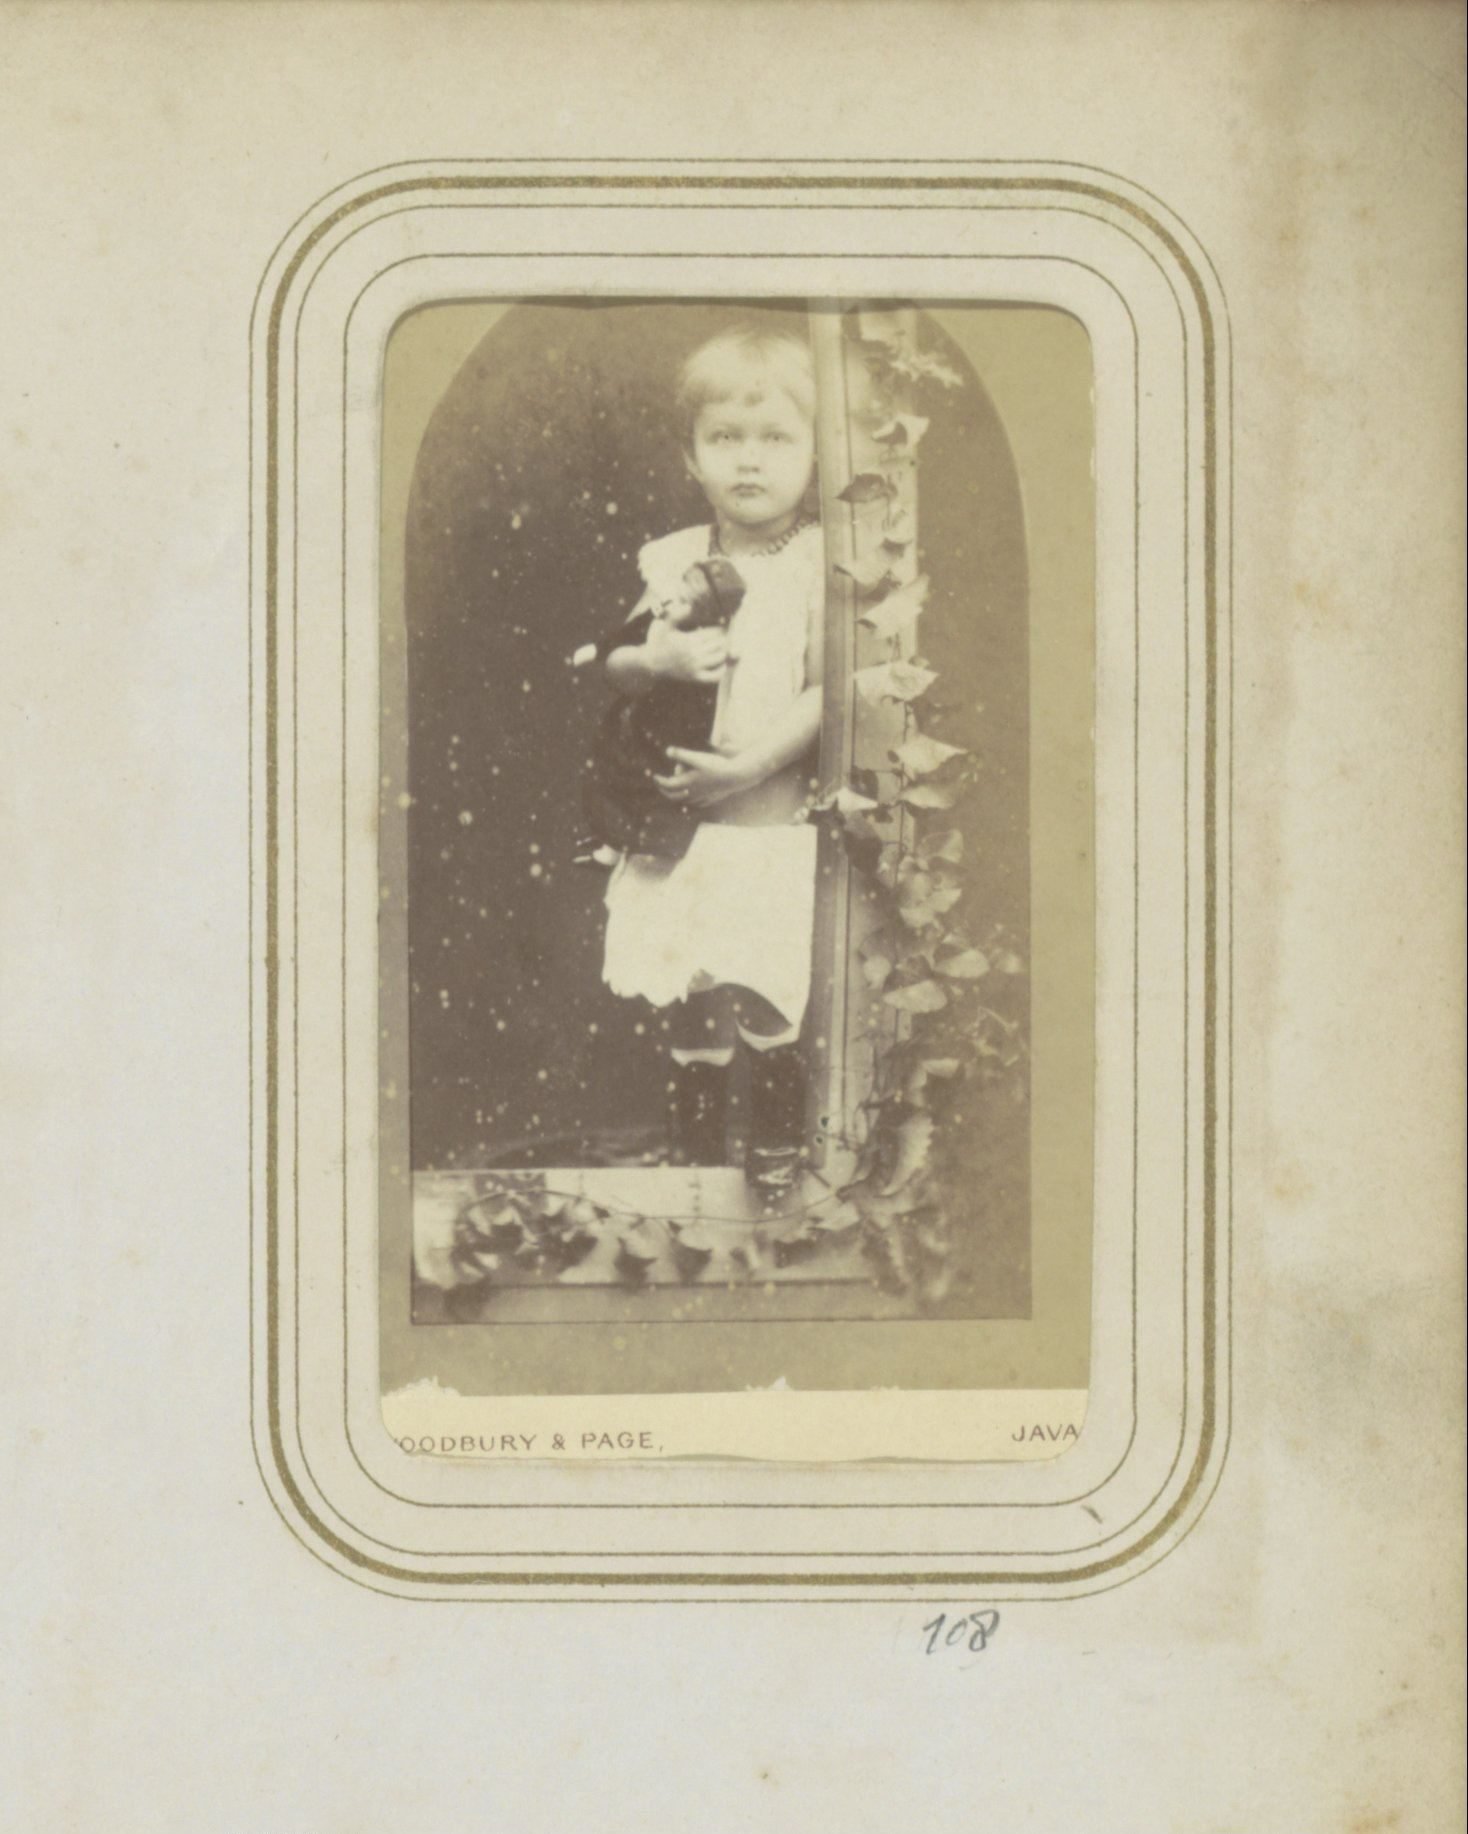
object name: carte de visite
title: Portret van een kind met een pop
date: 1857-1880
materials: cardboard, photographic support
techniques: albumen print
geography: java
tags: studio requisites ~ photographer, child, historical persons, family, relationship, descent, (playing with) dolls, dress, gown, necklace, java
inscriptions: address: ‘Java’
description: Onderdeel van Familiealbum van H.W.F. Ligtenberg en L.M. Swart met 149 foto's en cartes-de-visite.